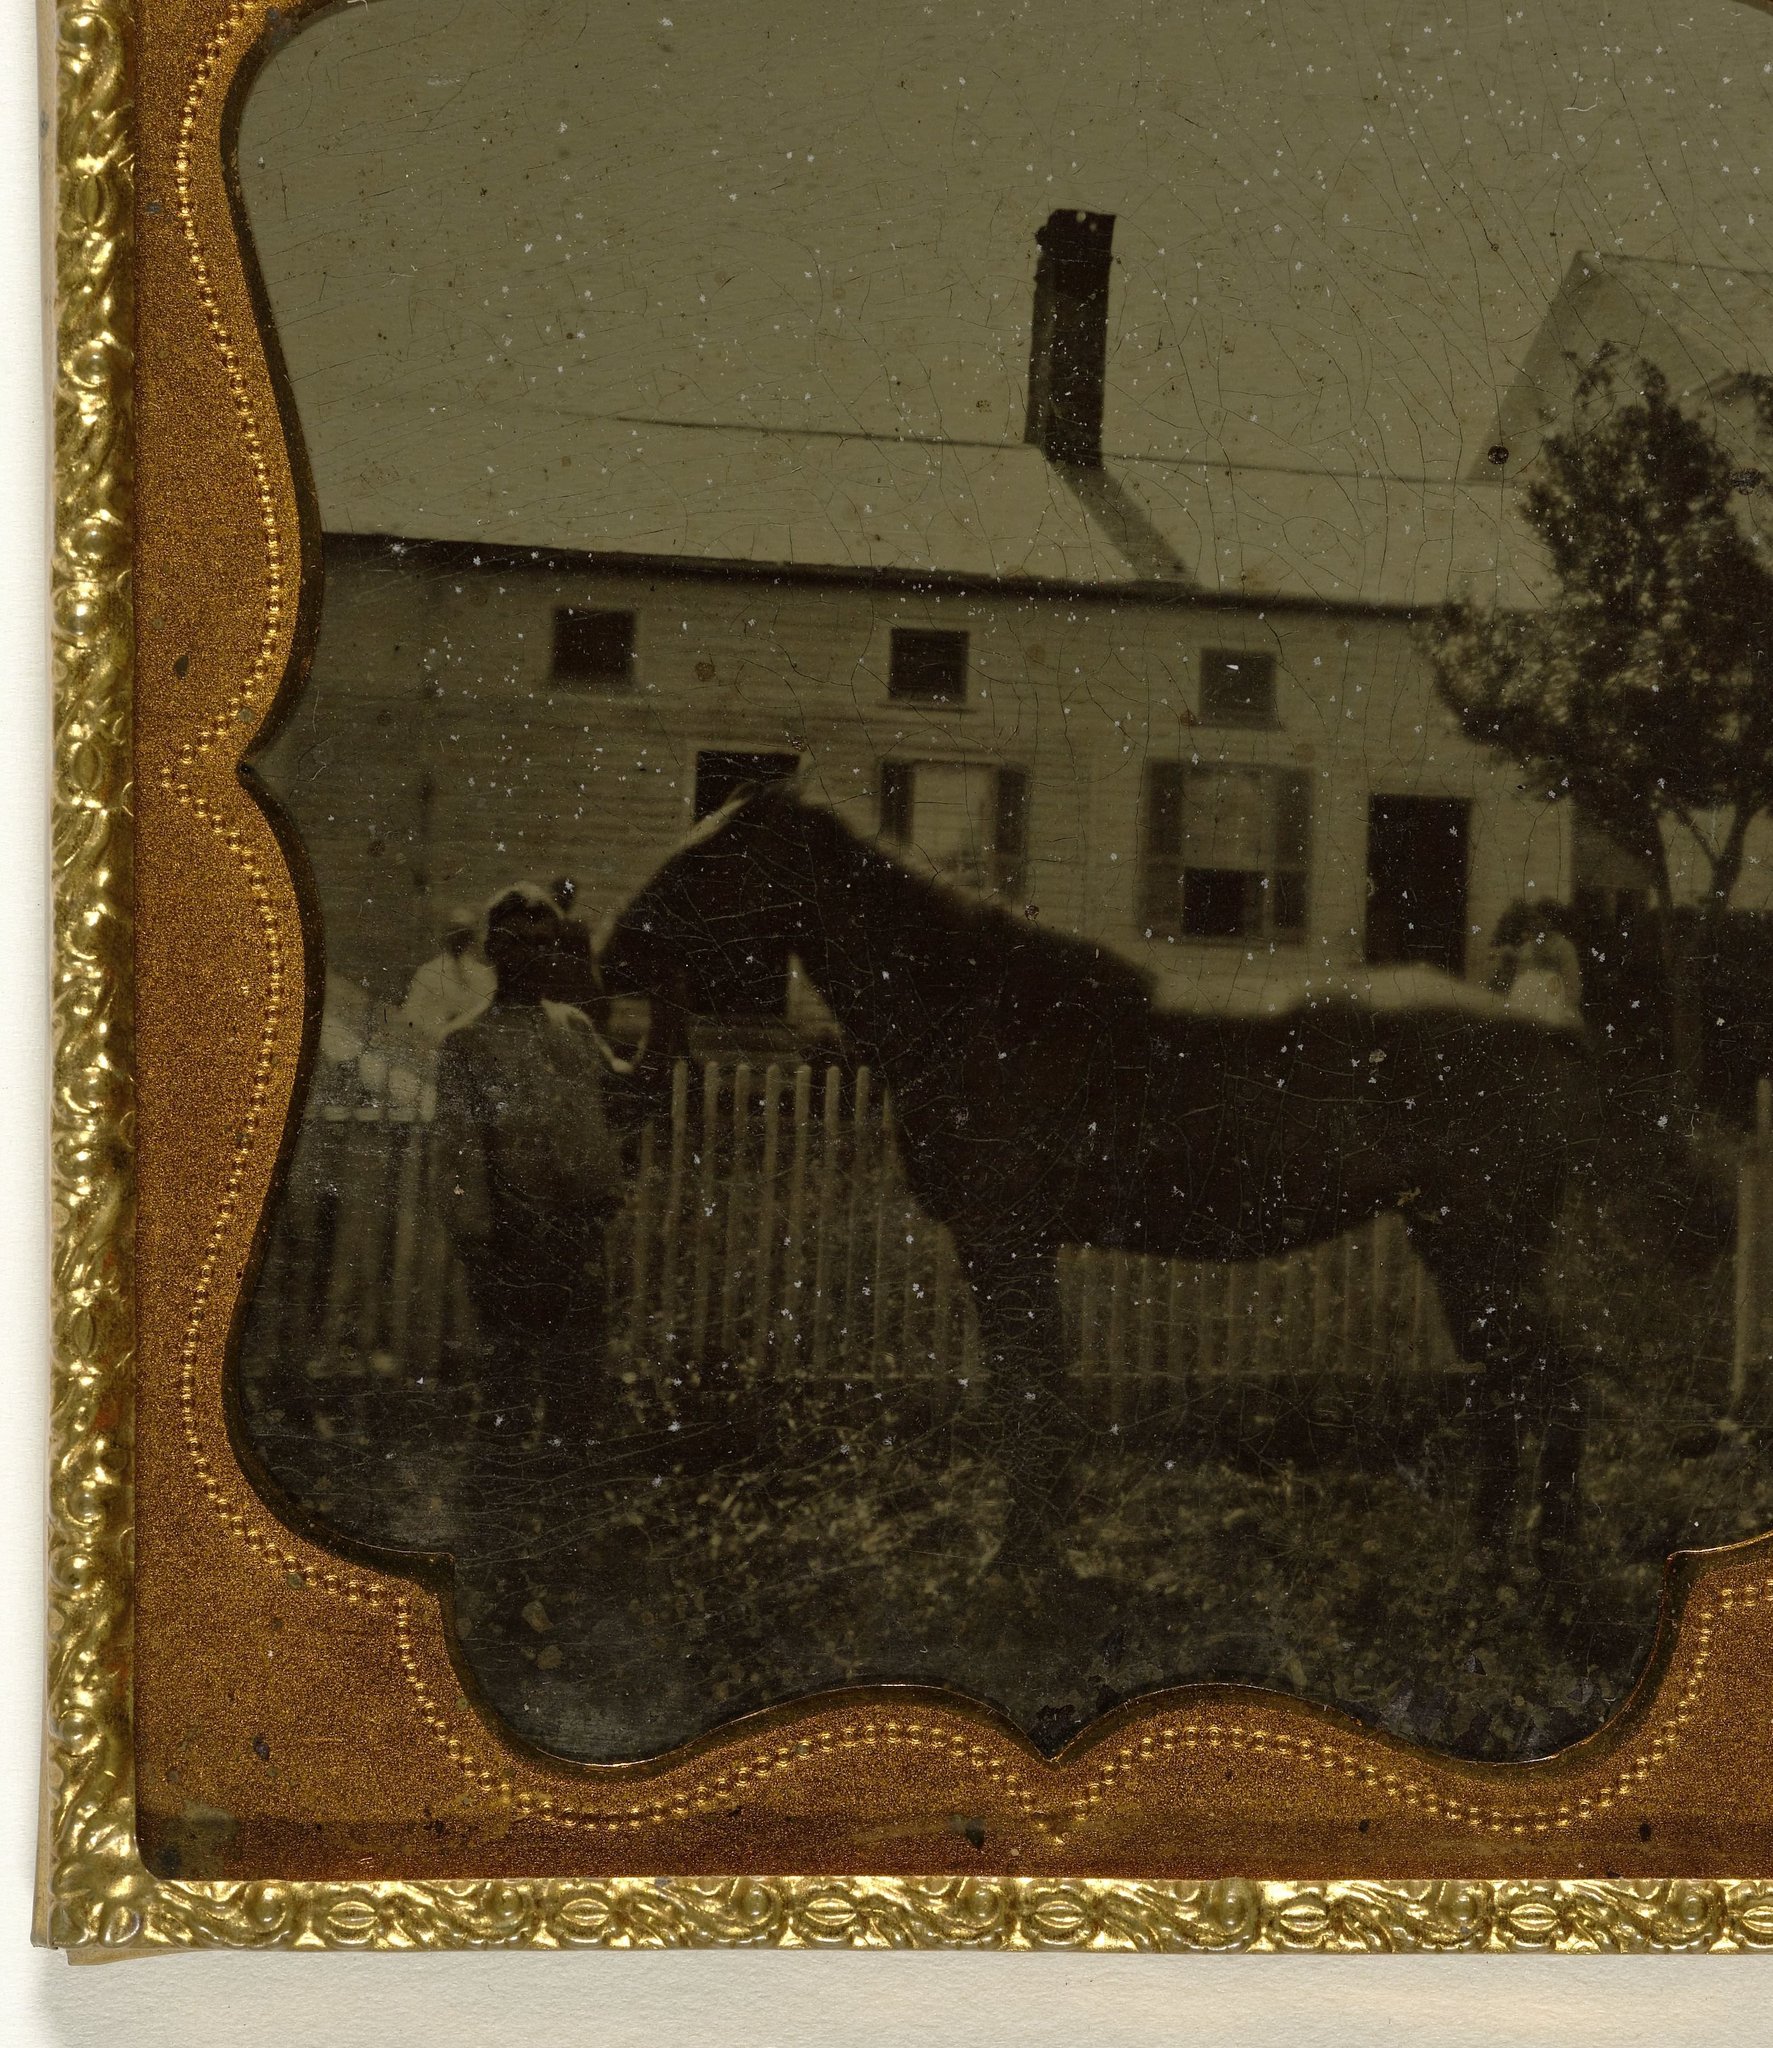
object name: photograph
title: Man en paard voor een huis, bij tegenlicht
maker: Anonymous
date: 1870-1910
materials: glass, metal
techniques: ferrotyping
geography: north and central america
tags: horse